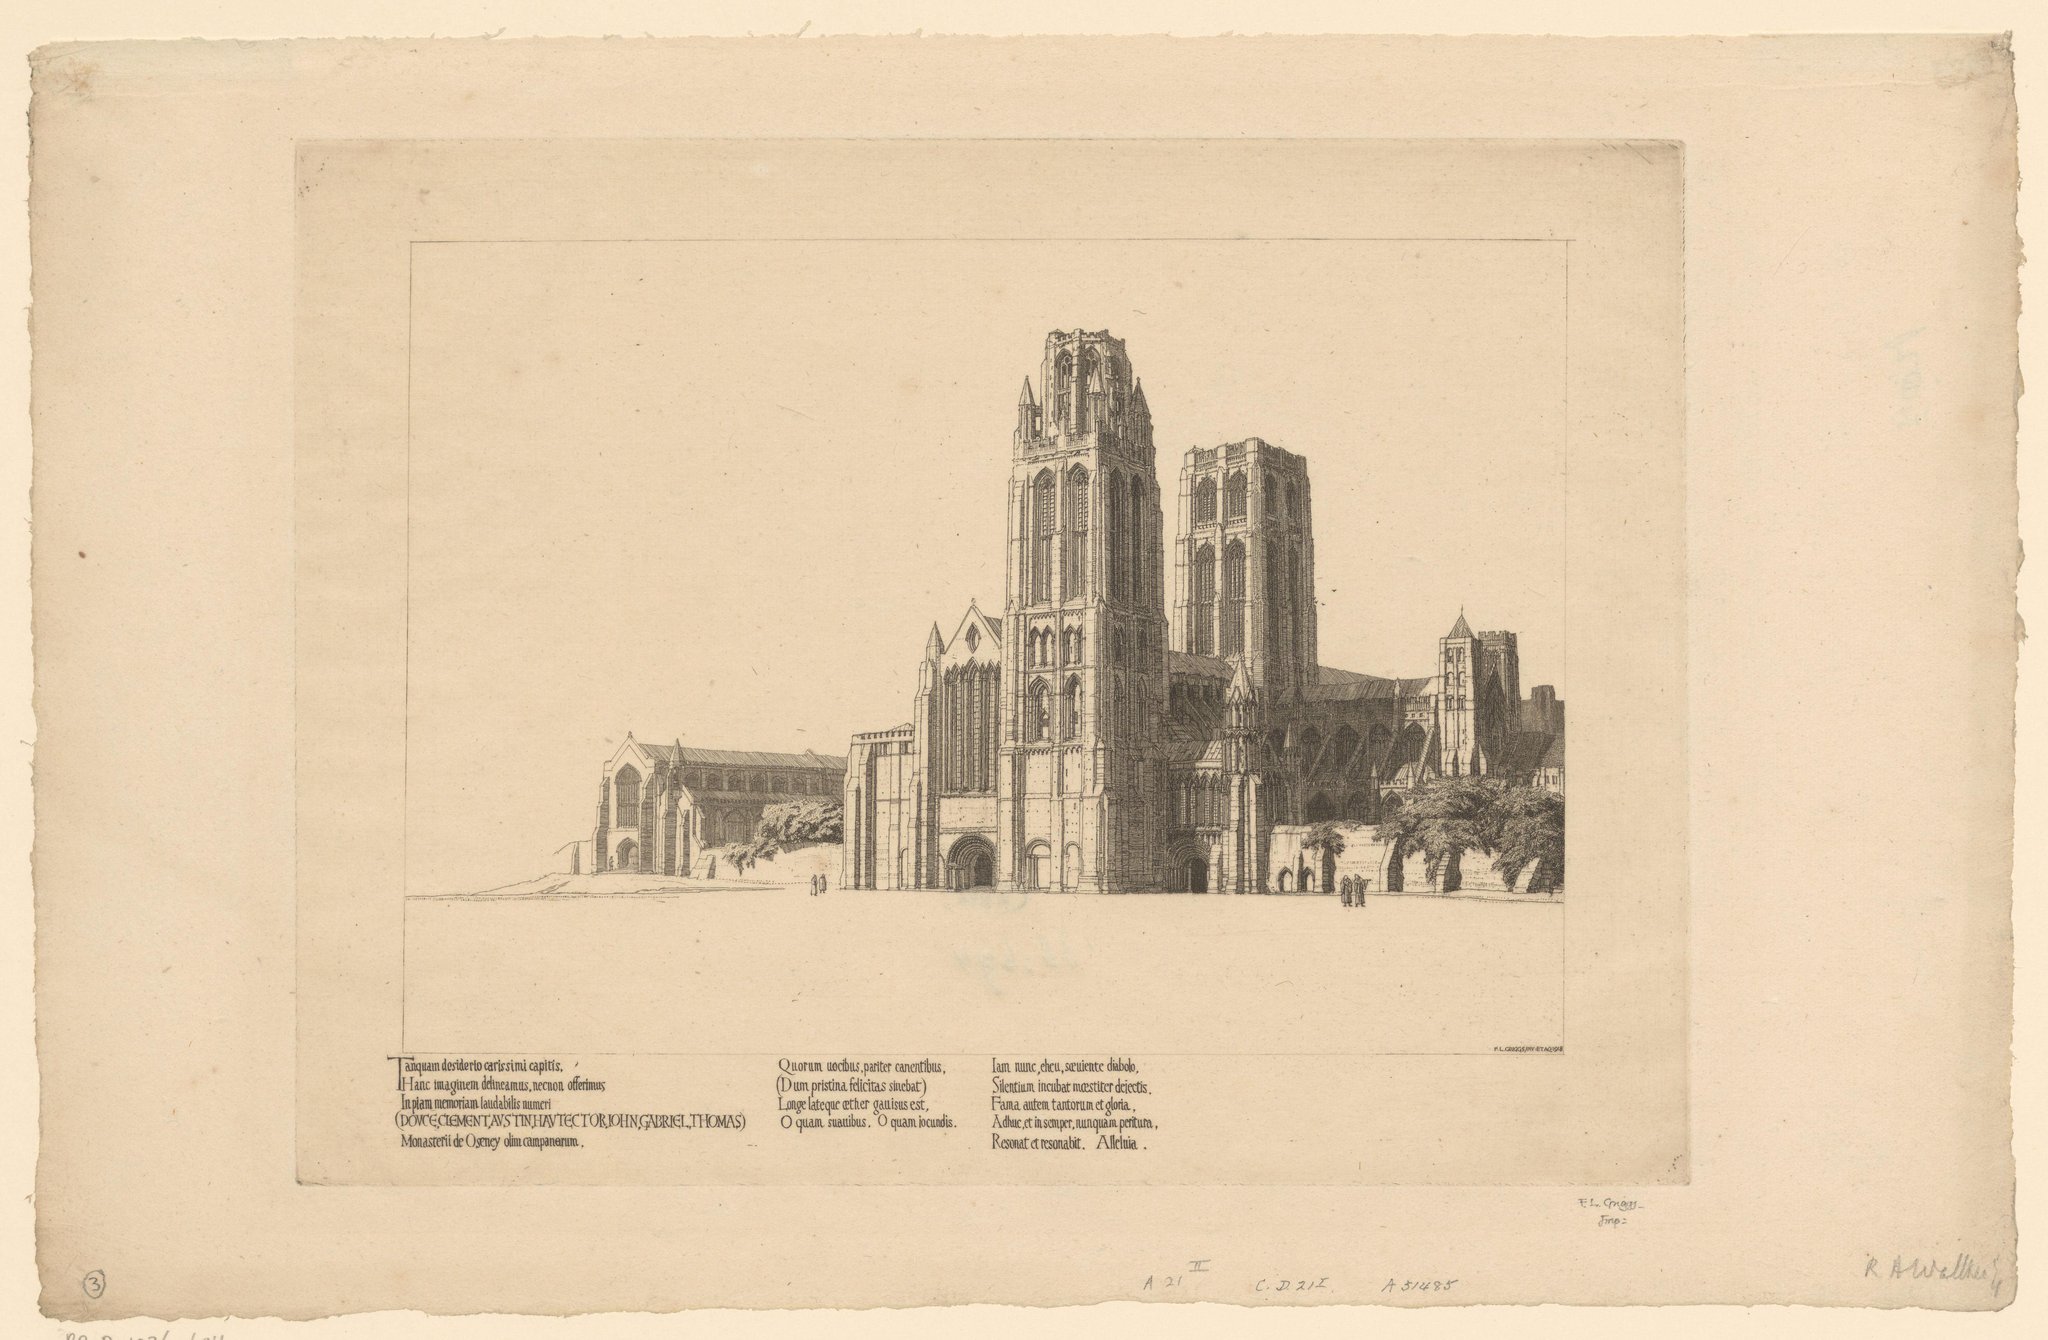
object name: print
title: The Minster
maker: frederick landseer maur griggs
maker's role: print maker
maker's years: 1876-1938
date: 1918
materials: paper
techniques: etching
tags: church (exterior)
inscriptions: collector's mark: Lugt 2228, signature: ‘F.L. Griggs’